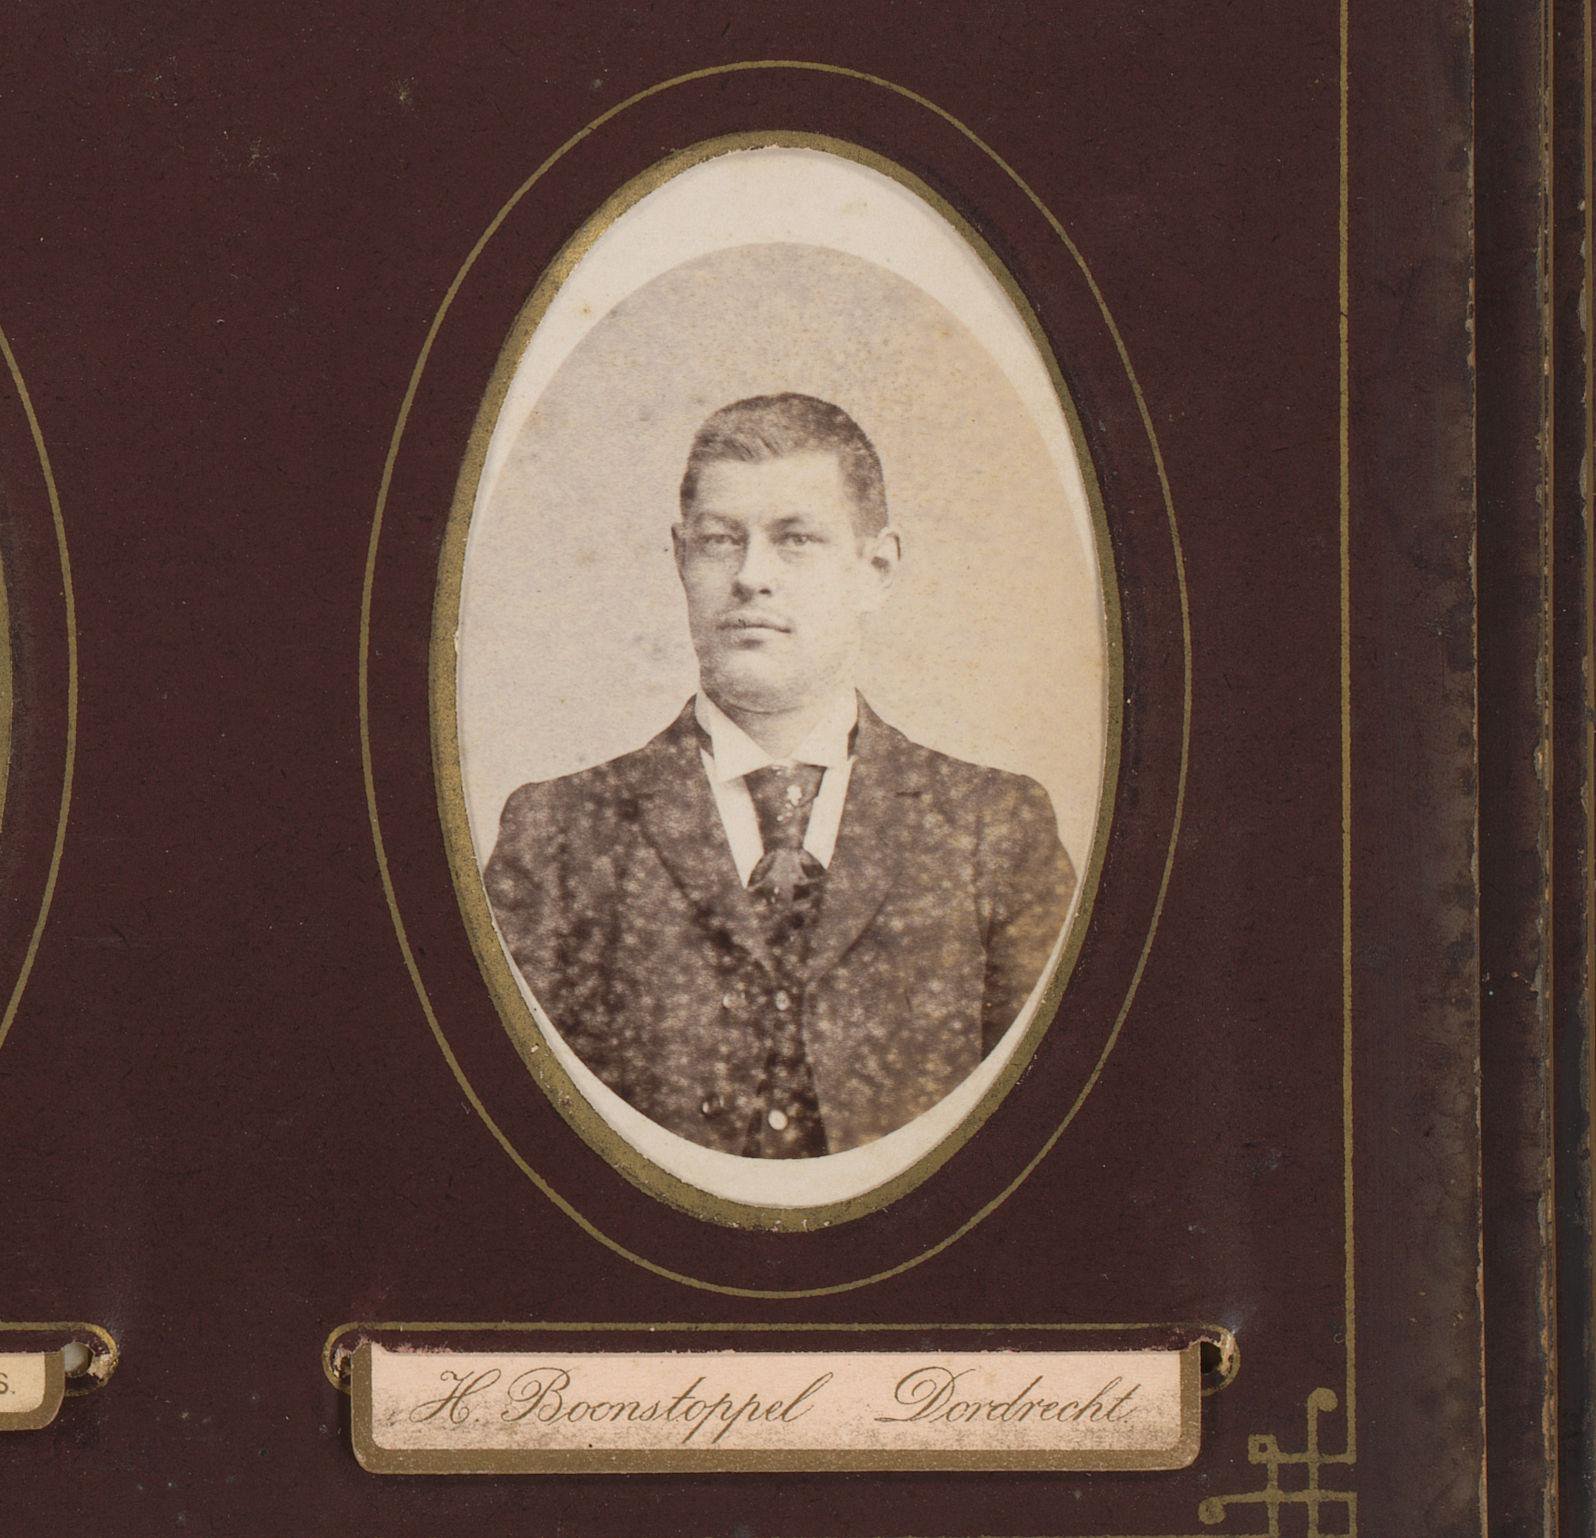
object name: album leaf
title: Portret van een man met stropdas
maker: hendrik boonstoppel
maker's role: fotograaf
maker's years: 1854-1924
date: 1880-1901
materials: cardboard, photographic support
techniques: albumen print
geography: dordrecht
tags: historical persons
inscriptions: inscription: ‘Photographie/ Instantanée/ H. Boonstoppel/ regt over/ het Postkantoor/ naast het verkooplokaal/ et Dordrecht/ Portretten kunnen op iedere groote nabesteld worden.’